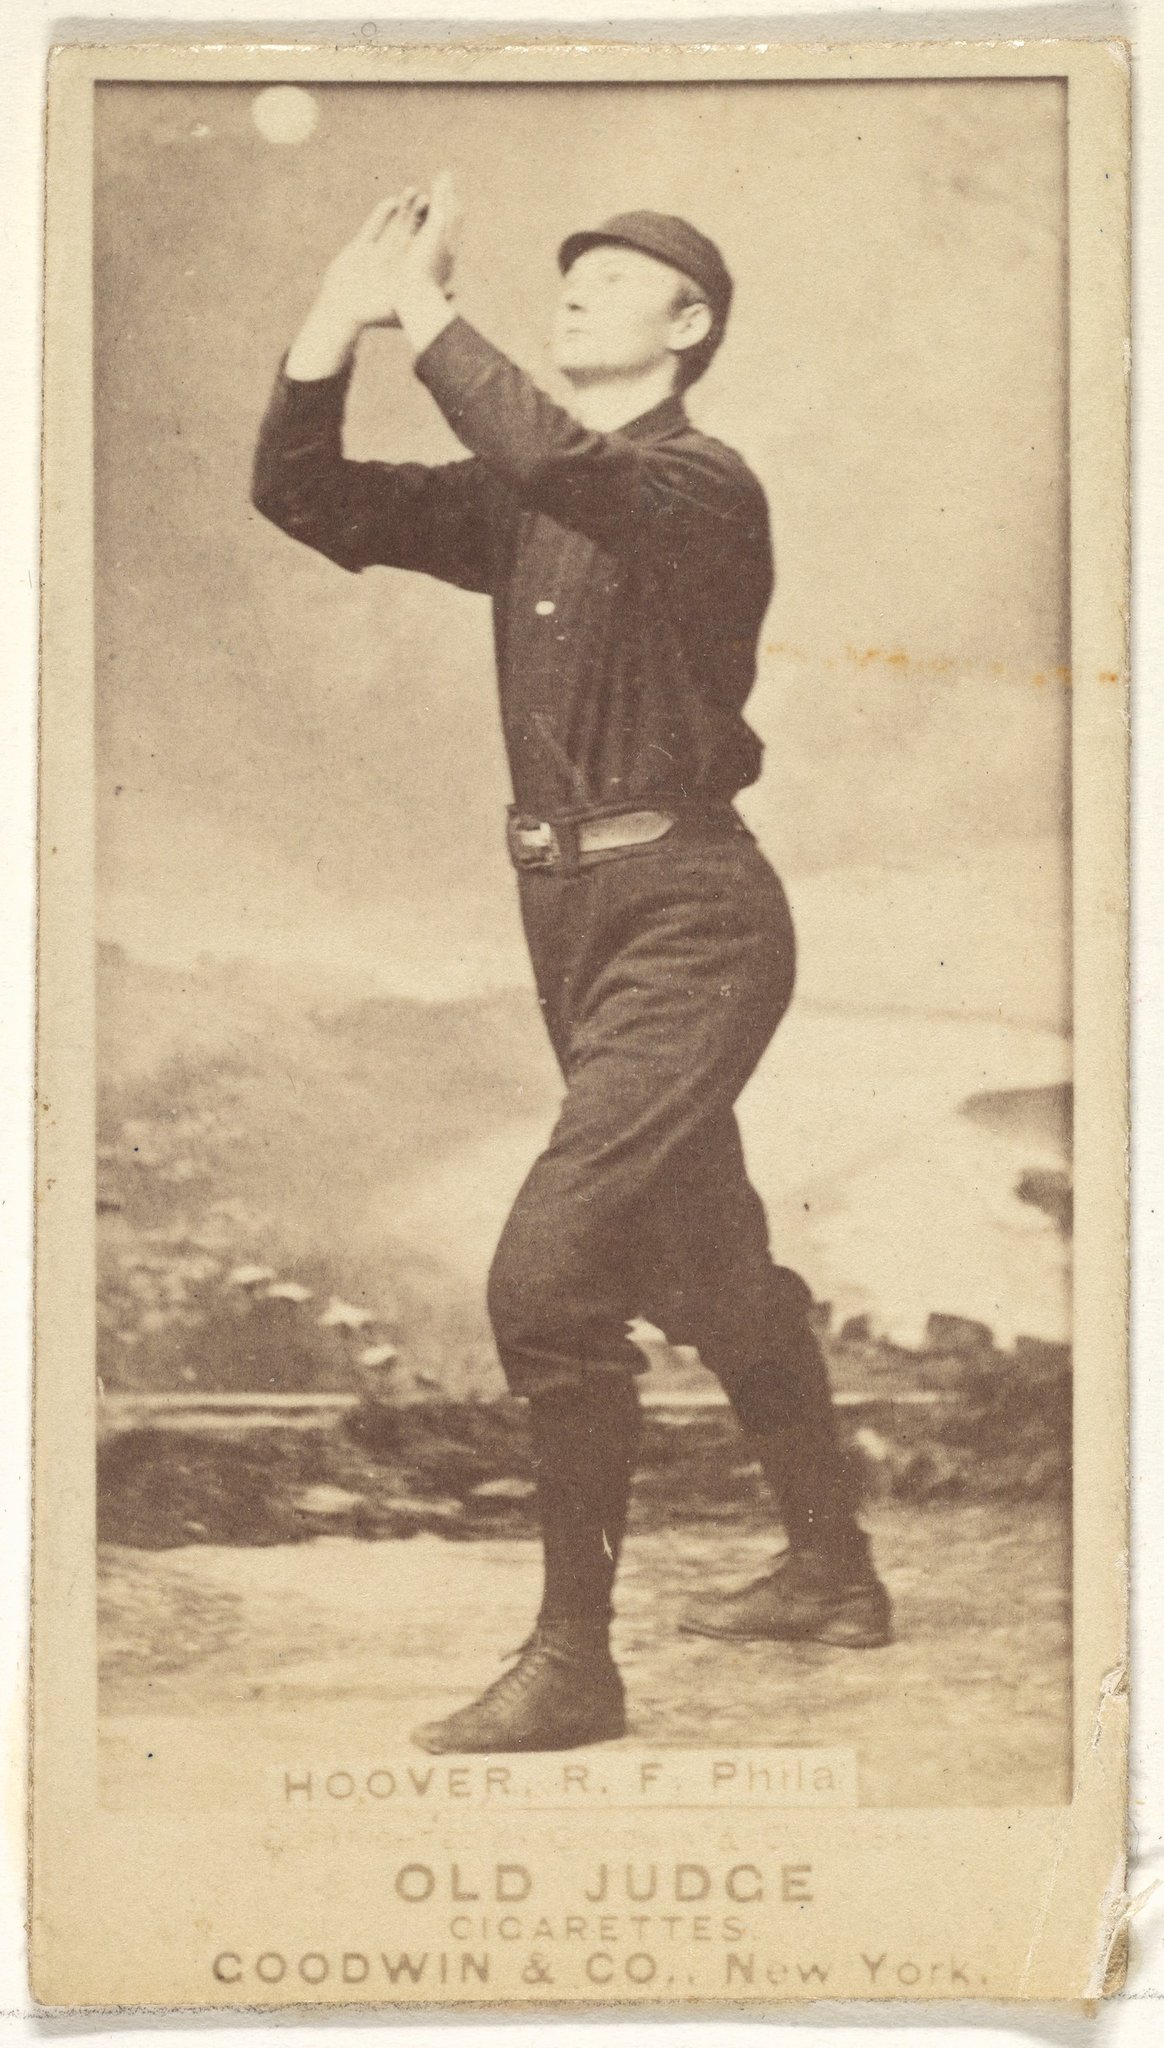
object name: baseball card, photograph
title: Hoover, Right Field, Philadelphia, from the Old Judge series (N172) for Old Judge Cigarettes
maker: goodwin & company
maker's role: publisher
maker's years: 1850-1950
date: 1887-1890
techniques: albumen silver print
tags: men,portraits,baseball,athletes